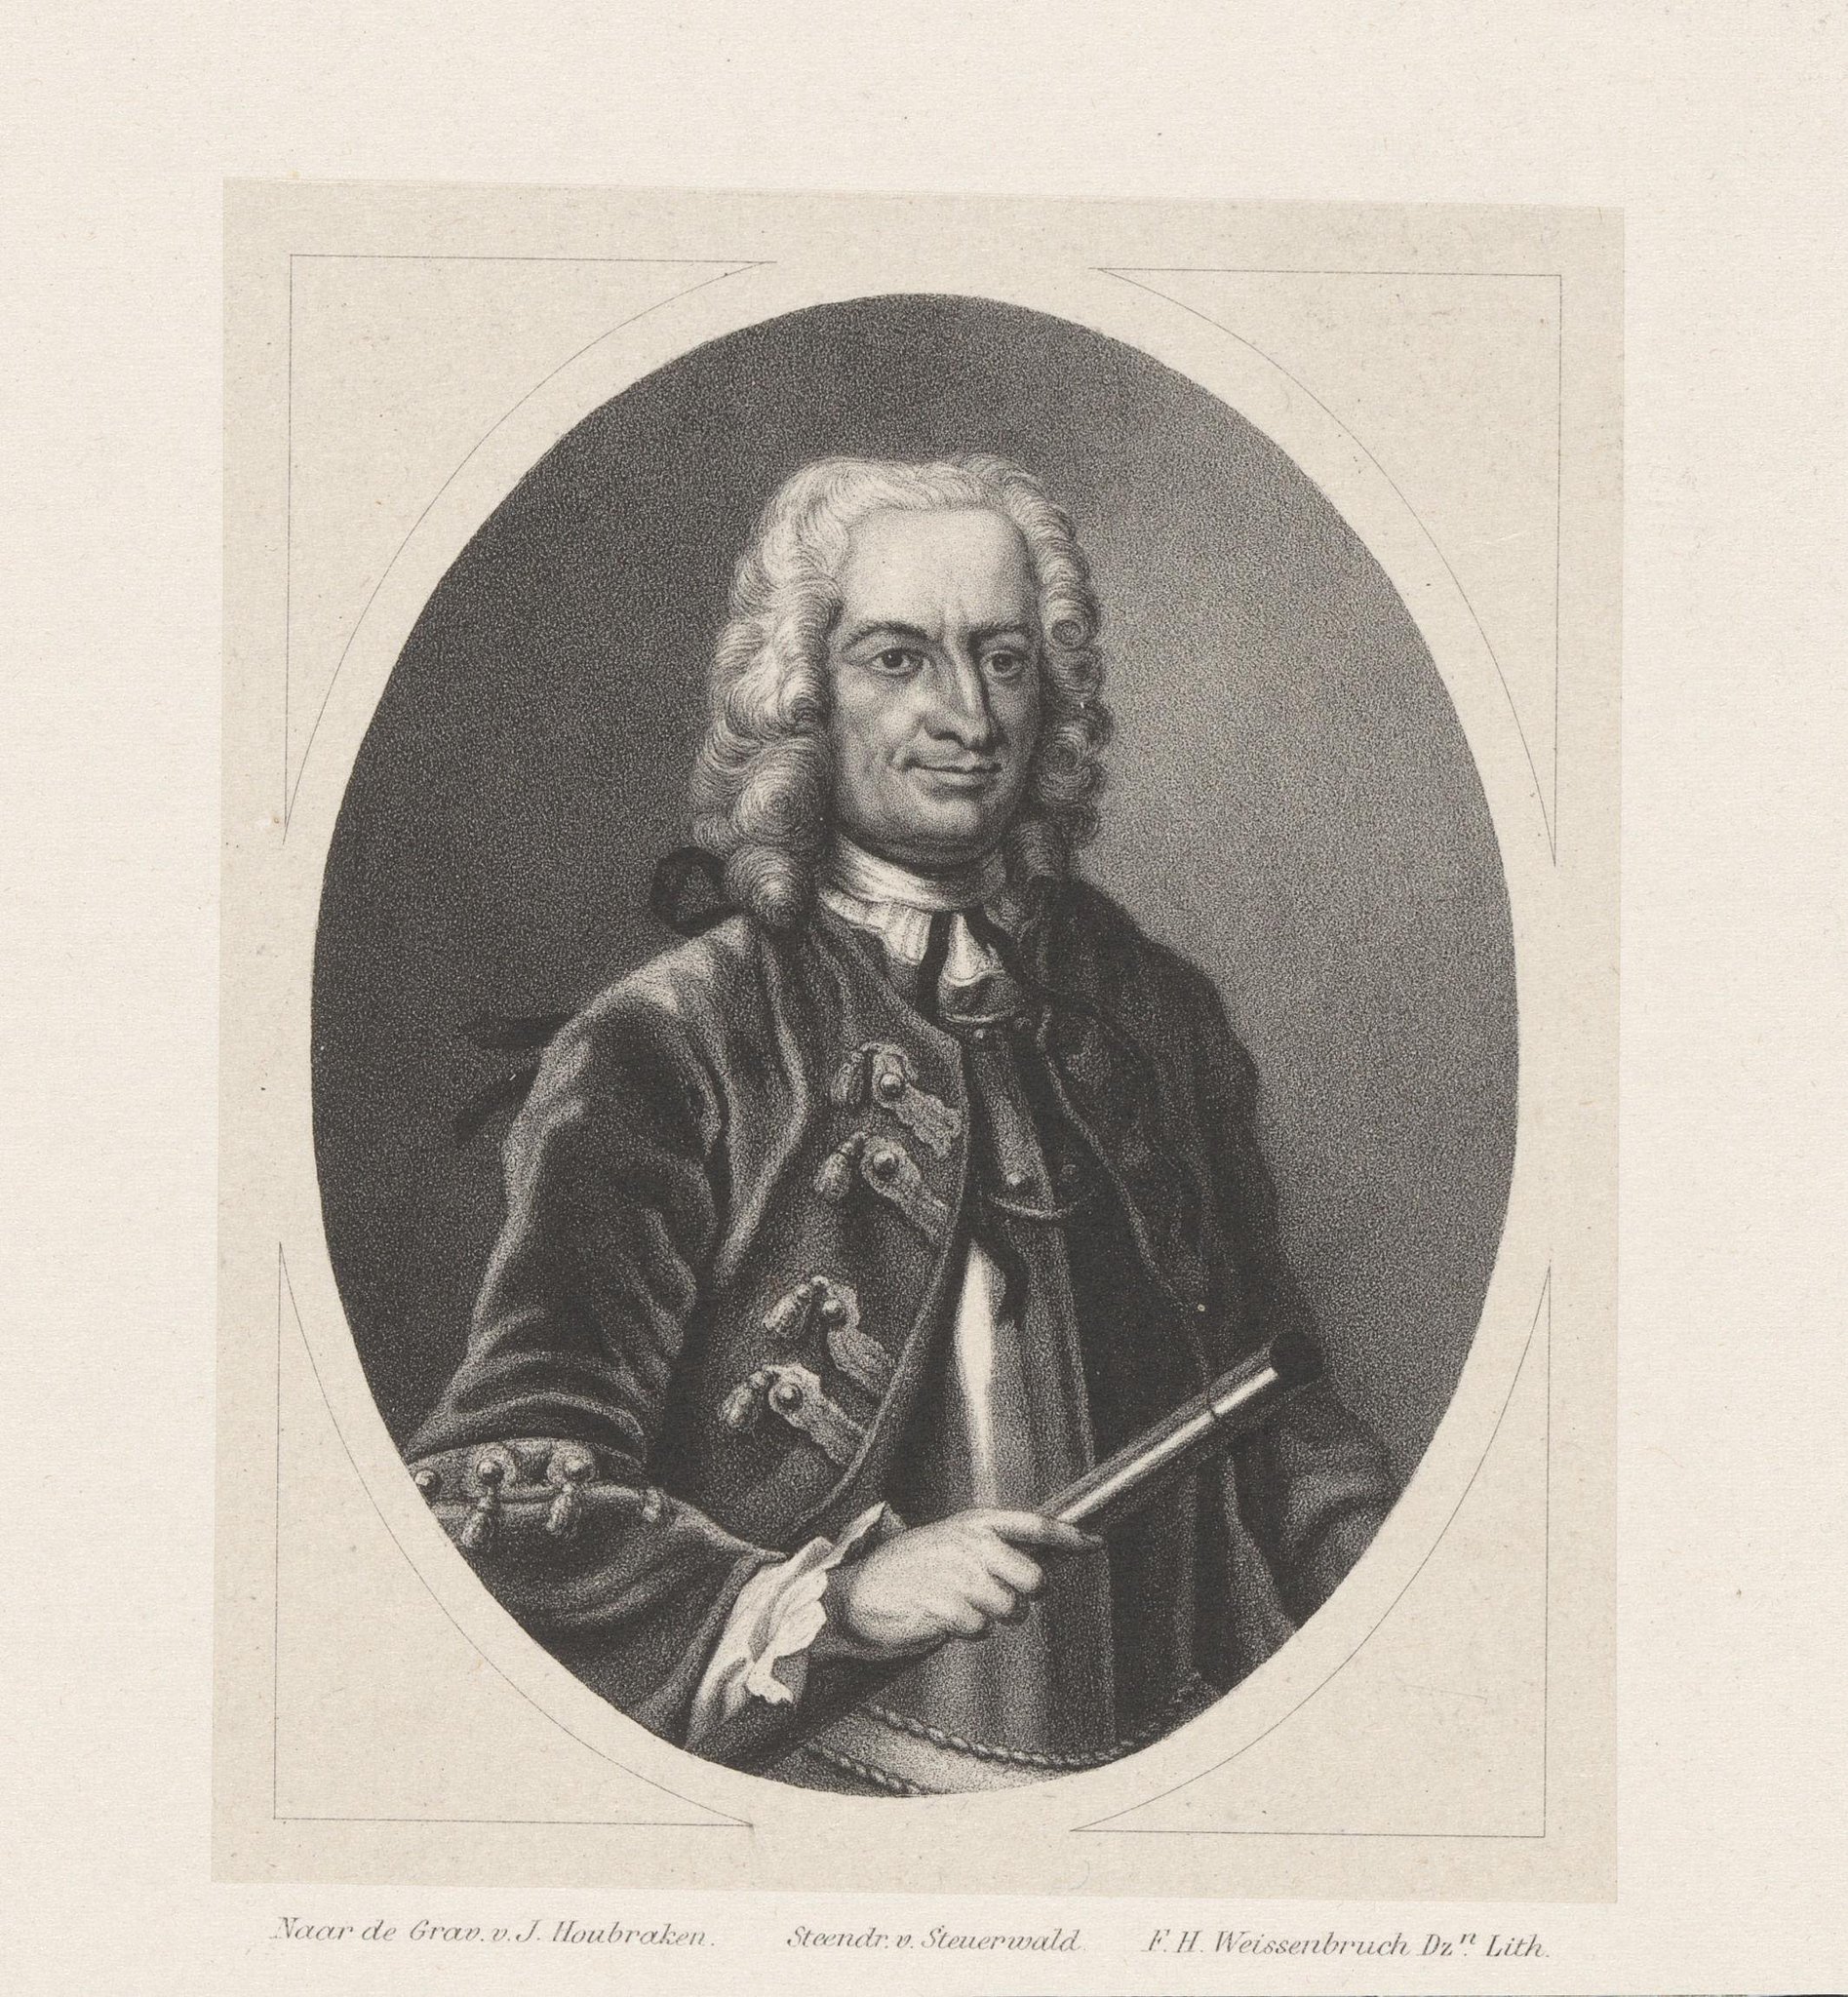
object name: book illustration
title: Portret van Cornelis Schrijver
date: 1861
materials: paper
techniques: lithograph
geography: the hague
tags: historical persons, portrait of a writer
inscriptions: collector's mark: Lugt 2228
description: Prent waarschijnlijk uit: Jonge, Johannes Cornelis de. Geschiedenis van het Nederlandsche zeewezen. Haarlem: Arie Cornelis Kruseman, 1861, dl. 4.